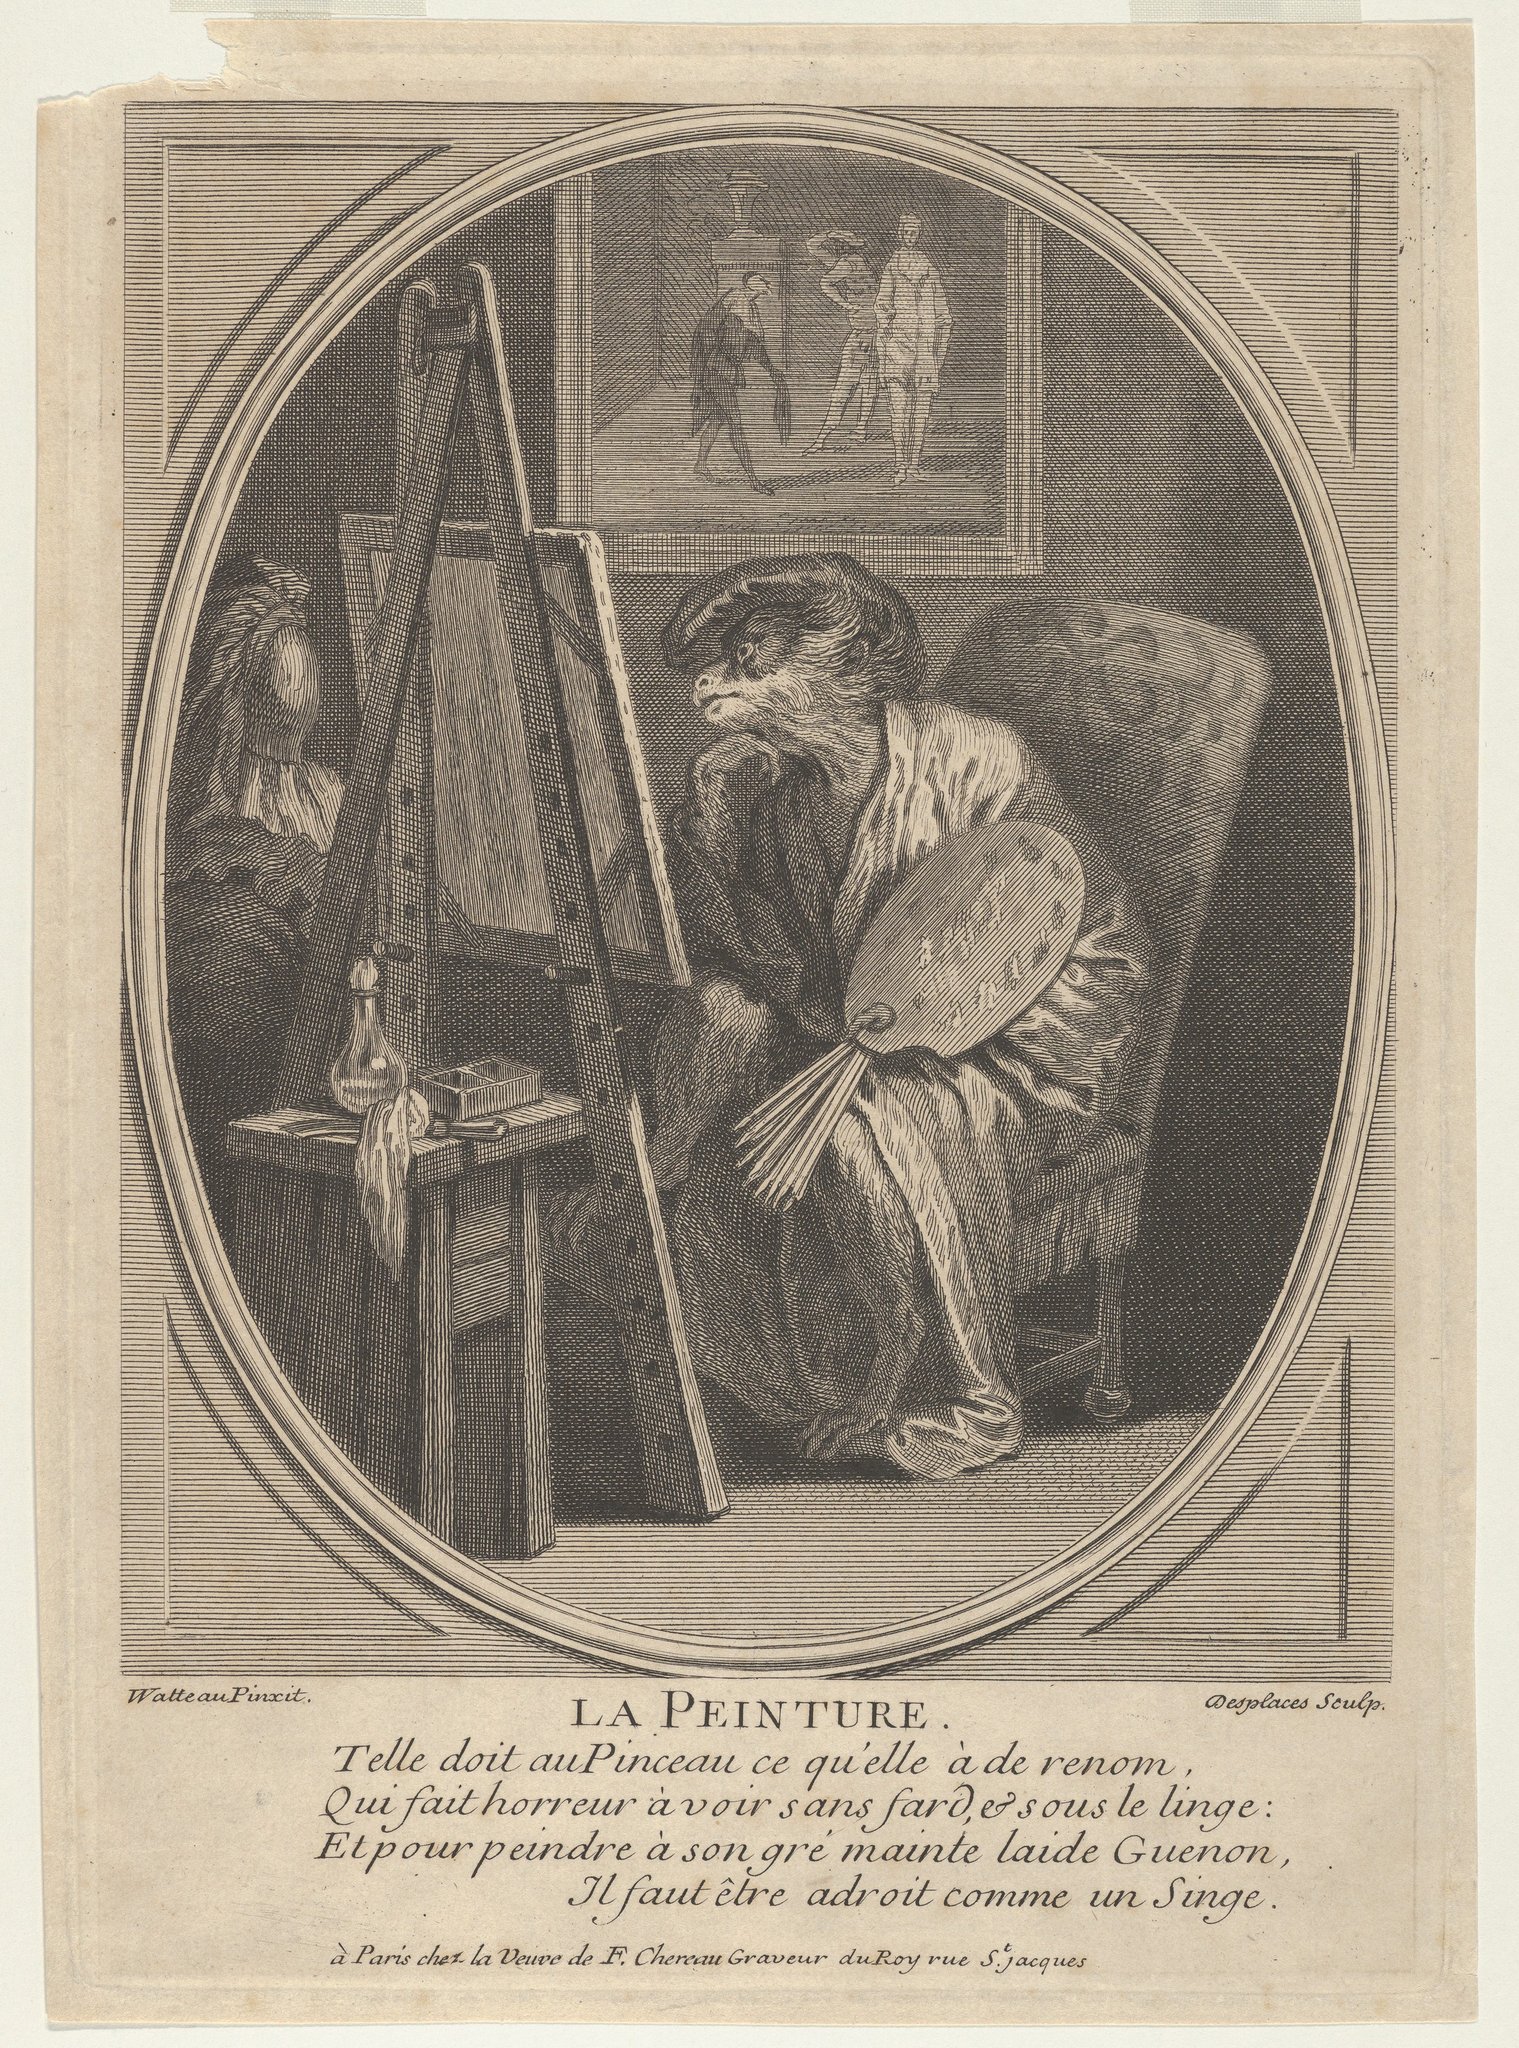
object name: print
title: Painting (La Peinture): a monkey seated at an easel, dressed in a robe and beret and holding a painter's palette, a framed painting hanging on the wall beyond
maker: louis desplaces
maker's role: artist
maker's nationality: french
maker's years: 1682-1739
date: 1700-1739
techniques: engraving, etching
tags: painting,monkeys,easels,palettes